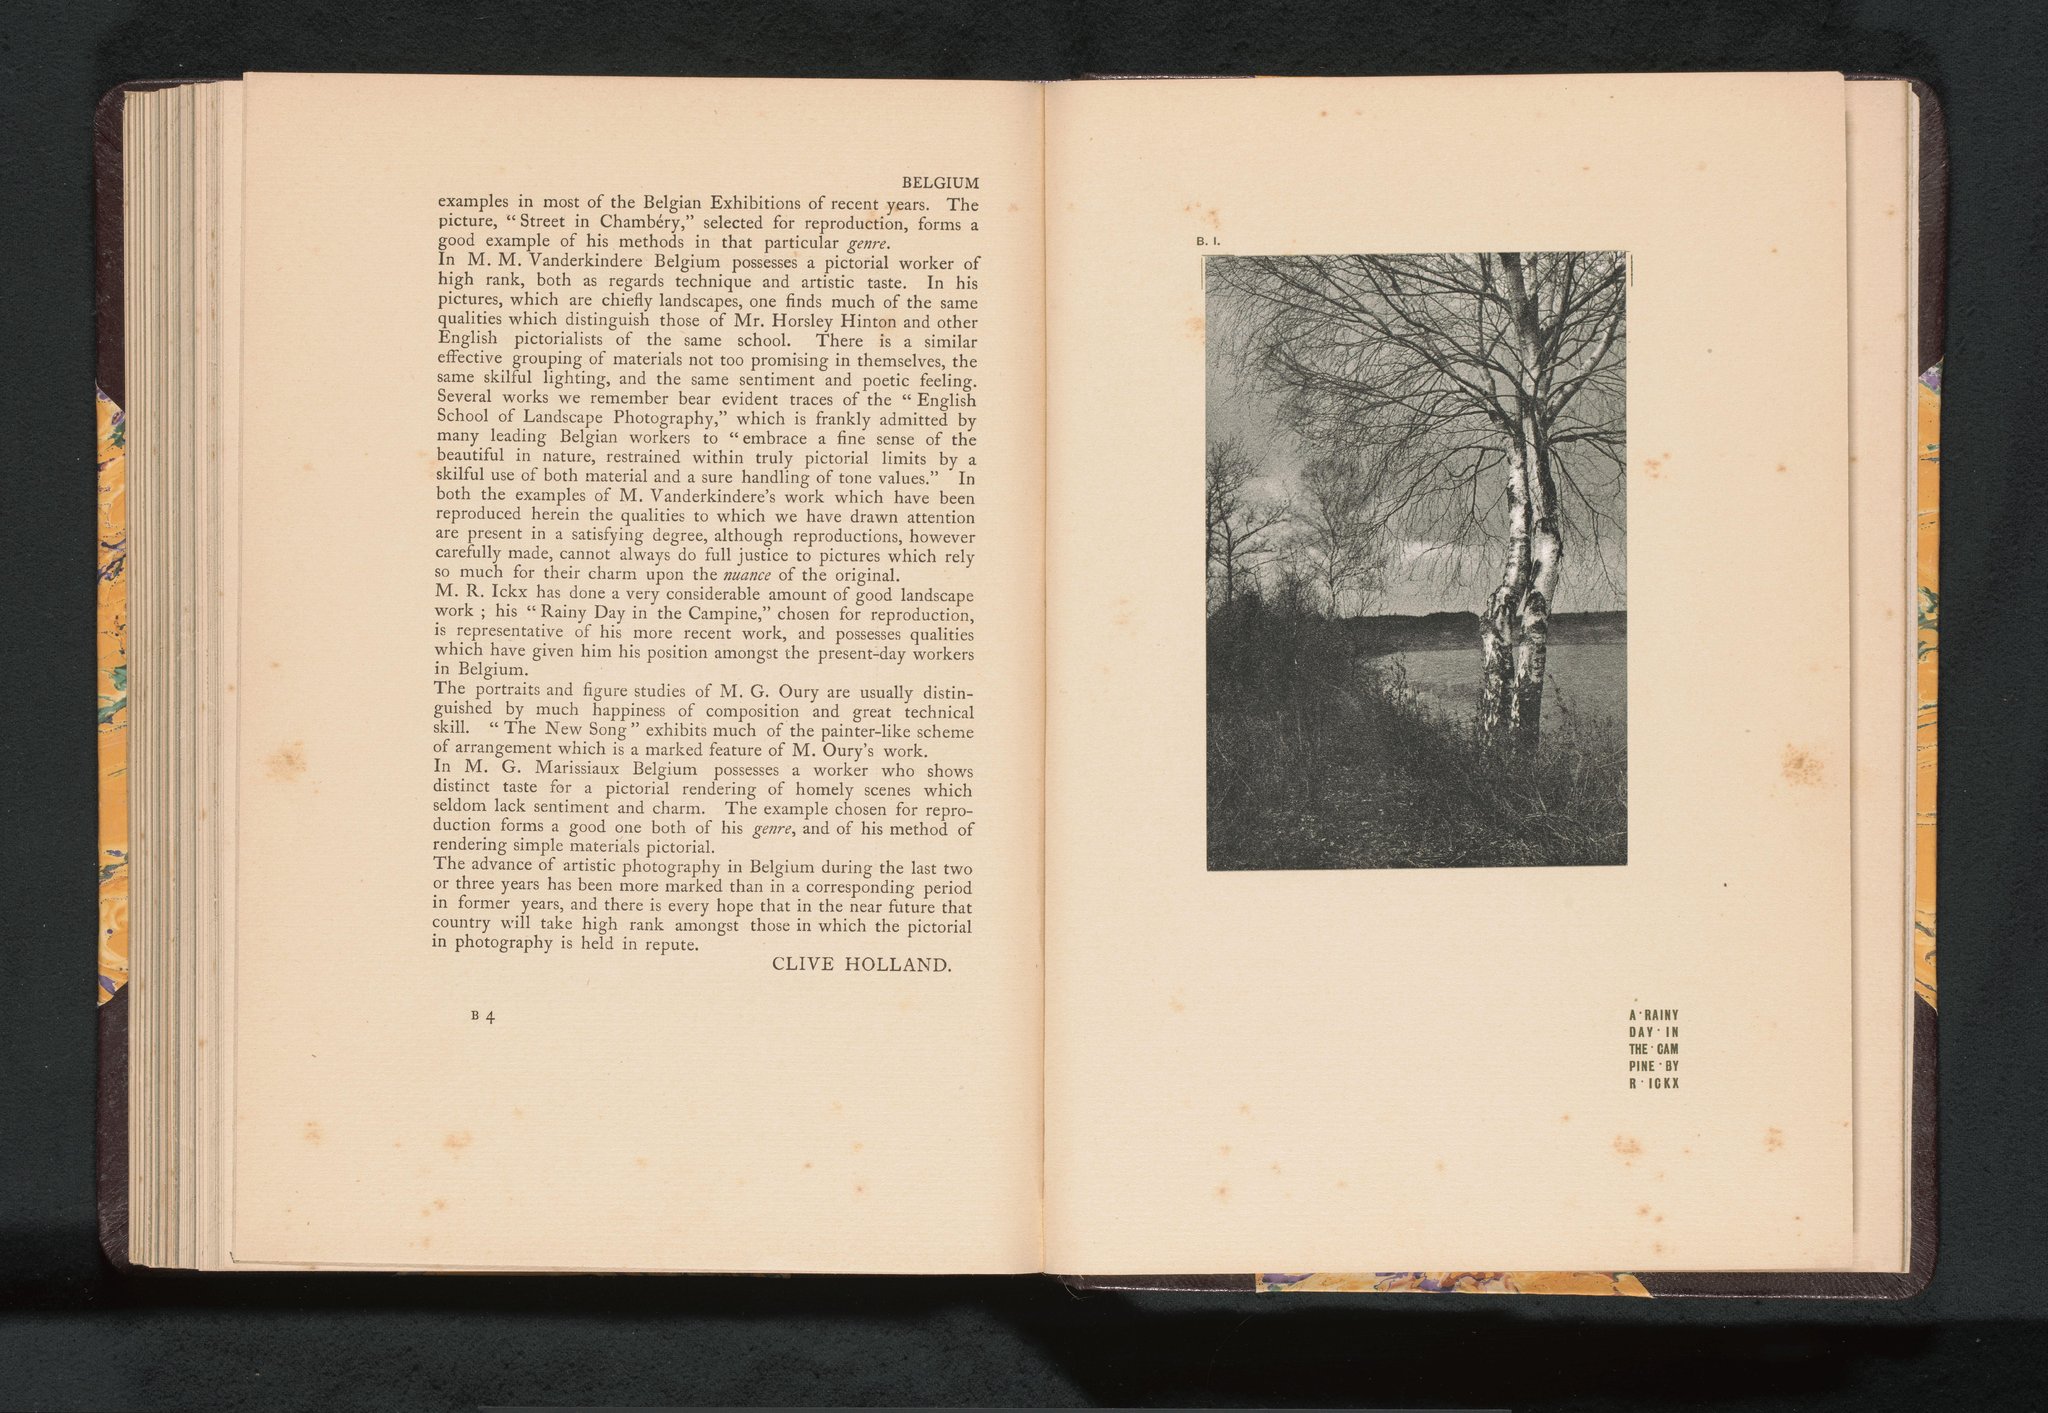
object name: page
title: Landschap in de Kempen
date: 1900-1905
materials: paper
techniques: collo-autotype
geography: kempen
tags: landscapes with waters, waterscapes, seascapes (in the temperate zone)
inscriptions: inscription: ‘B. I.’, inscription: ‘A rainy day in the Campine by R. Ickx’